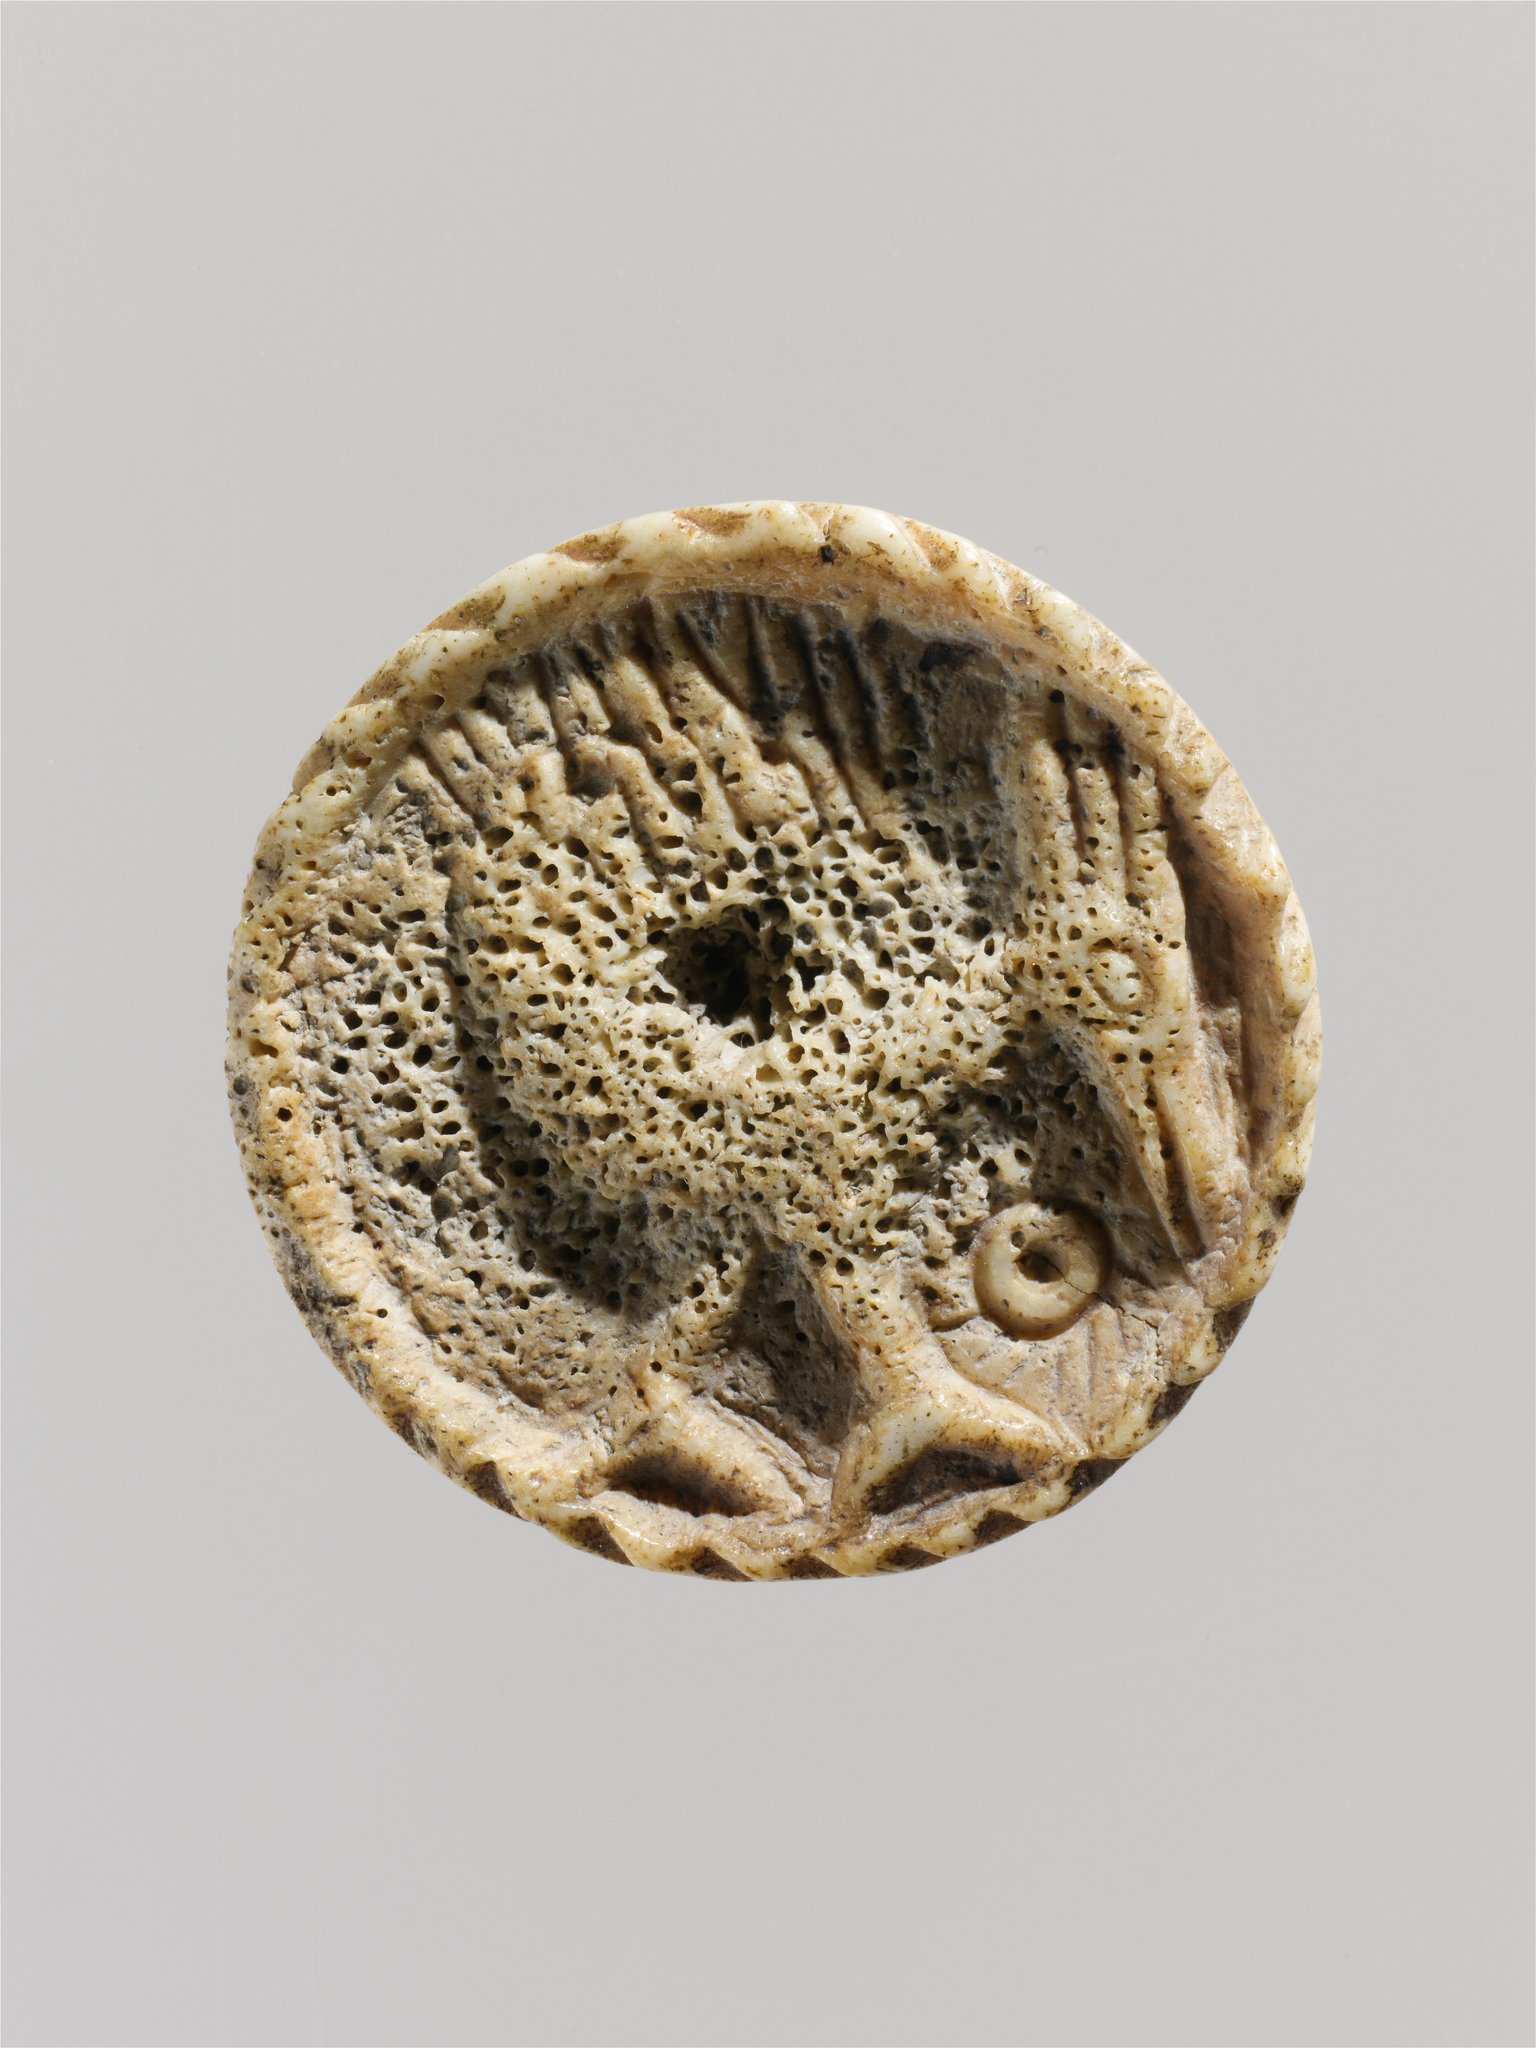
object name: game piece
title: Game Piece with a Bird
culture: french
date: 1050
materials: bone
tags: birds